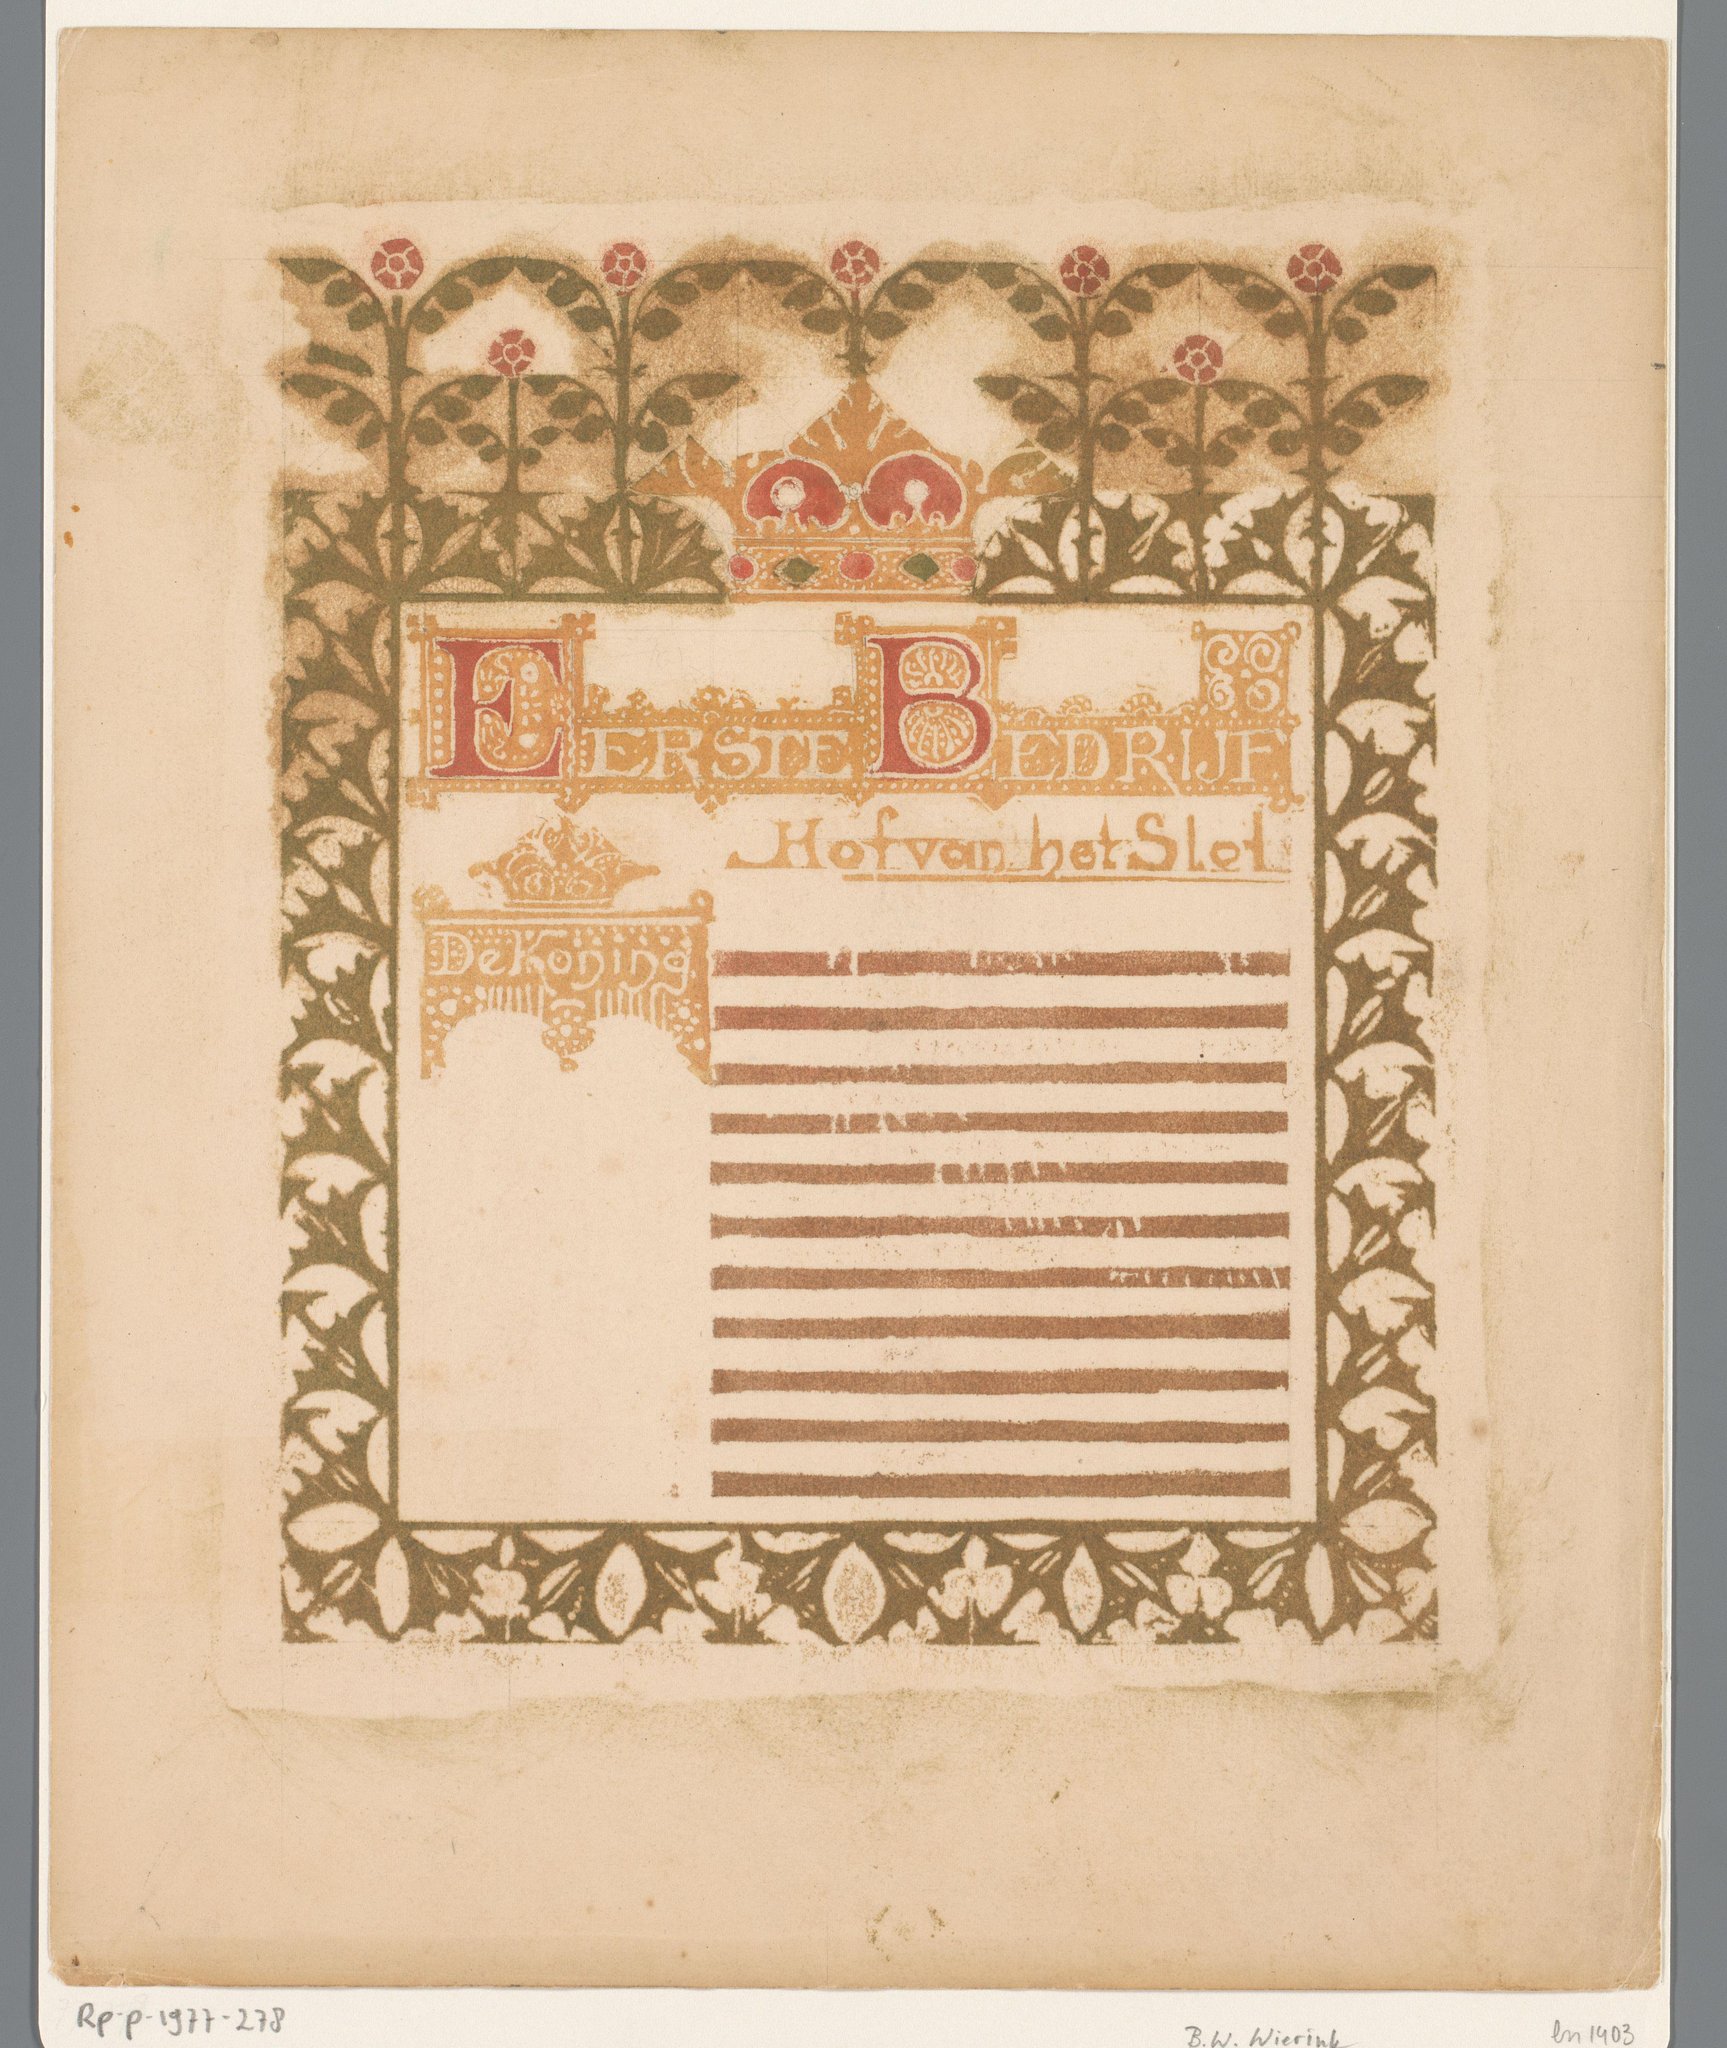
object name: print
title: Eerste Bedrijf / Hof van het slot / De koning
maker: bernard willem wierink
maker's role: draughtsman, print maker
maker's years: 1856-1939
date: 1935-1938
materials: paper, pencil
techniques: batik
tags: crown (symbol of sovereignty), flowers ~ ornament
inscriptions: collector's mark: Lugt 2228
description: Eén van twintig bladen waarvan 16 proefdrukken zijn voor één en dezelfde illustratie van een (onbekend) toneelstuk.